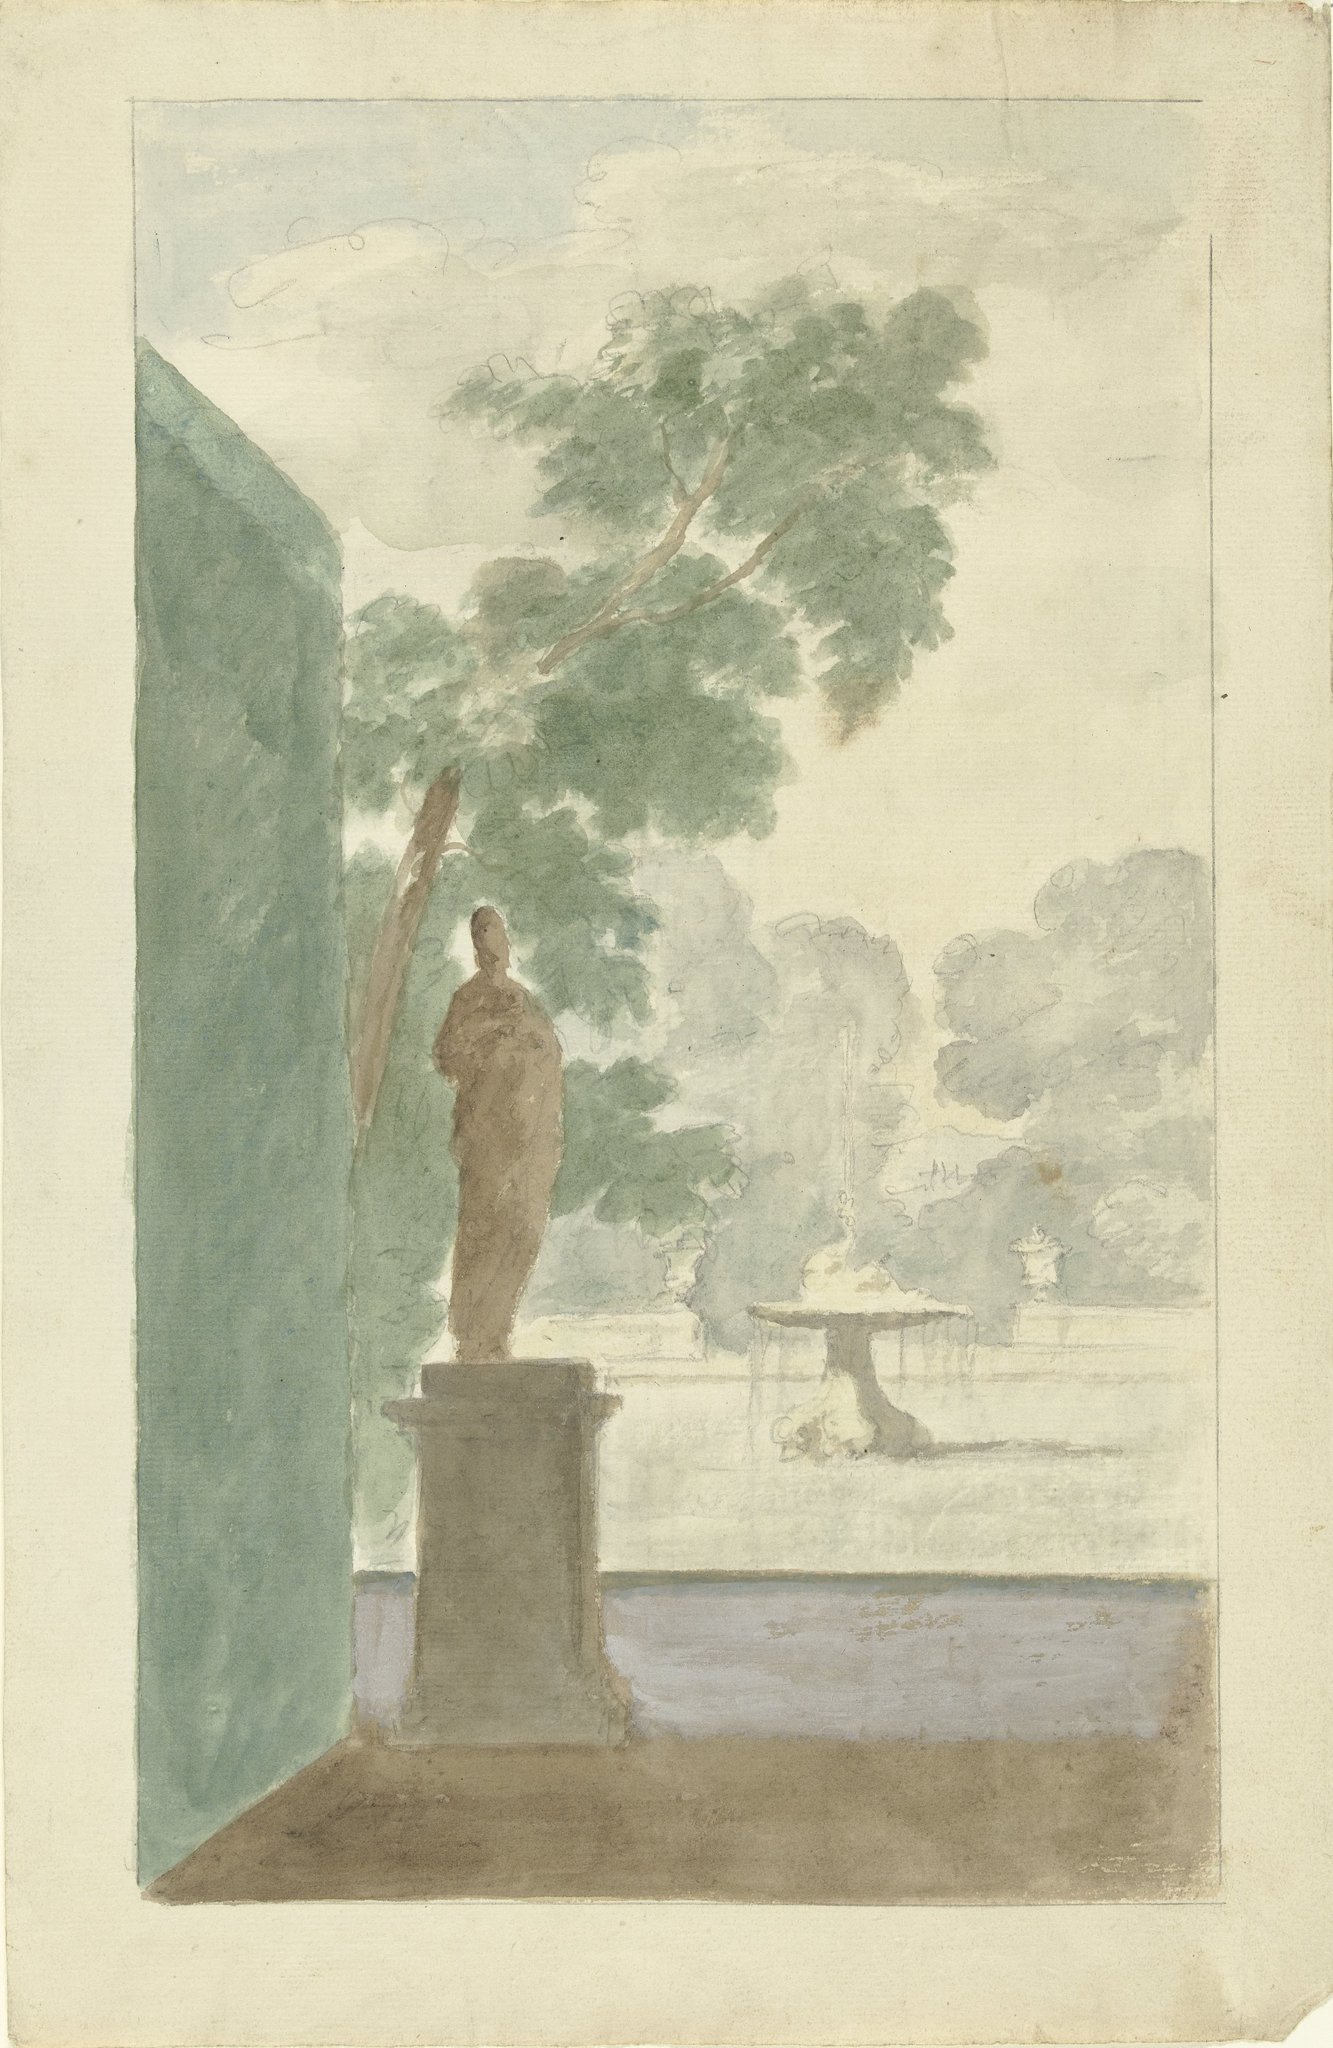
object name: drawing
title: Design for a Wall Decoration in a Hall: View of a Garden with a Statue, Fountain and Urns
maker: dionys van nijmegen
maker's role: draughtsman, painter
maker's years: 1705-1798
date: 1715-1798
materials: paint, paper, pencil, watercolor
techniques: brush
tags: garden